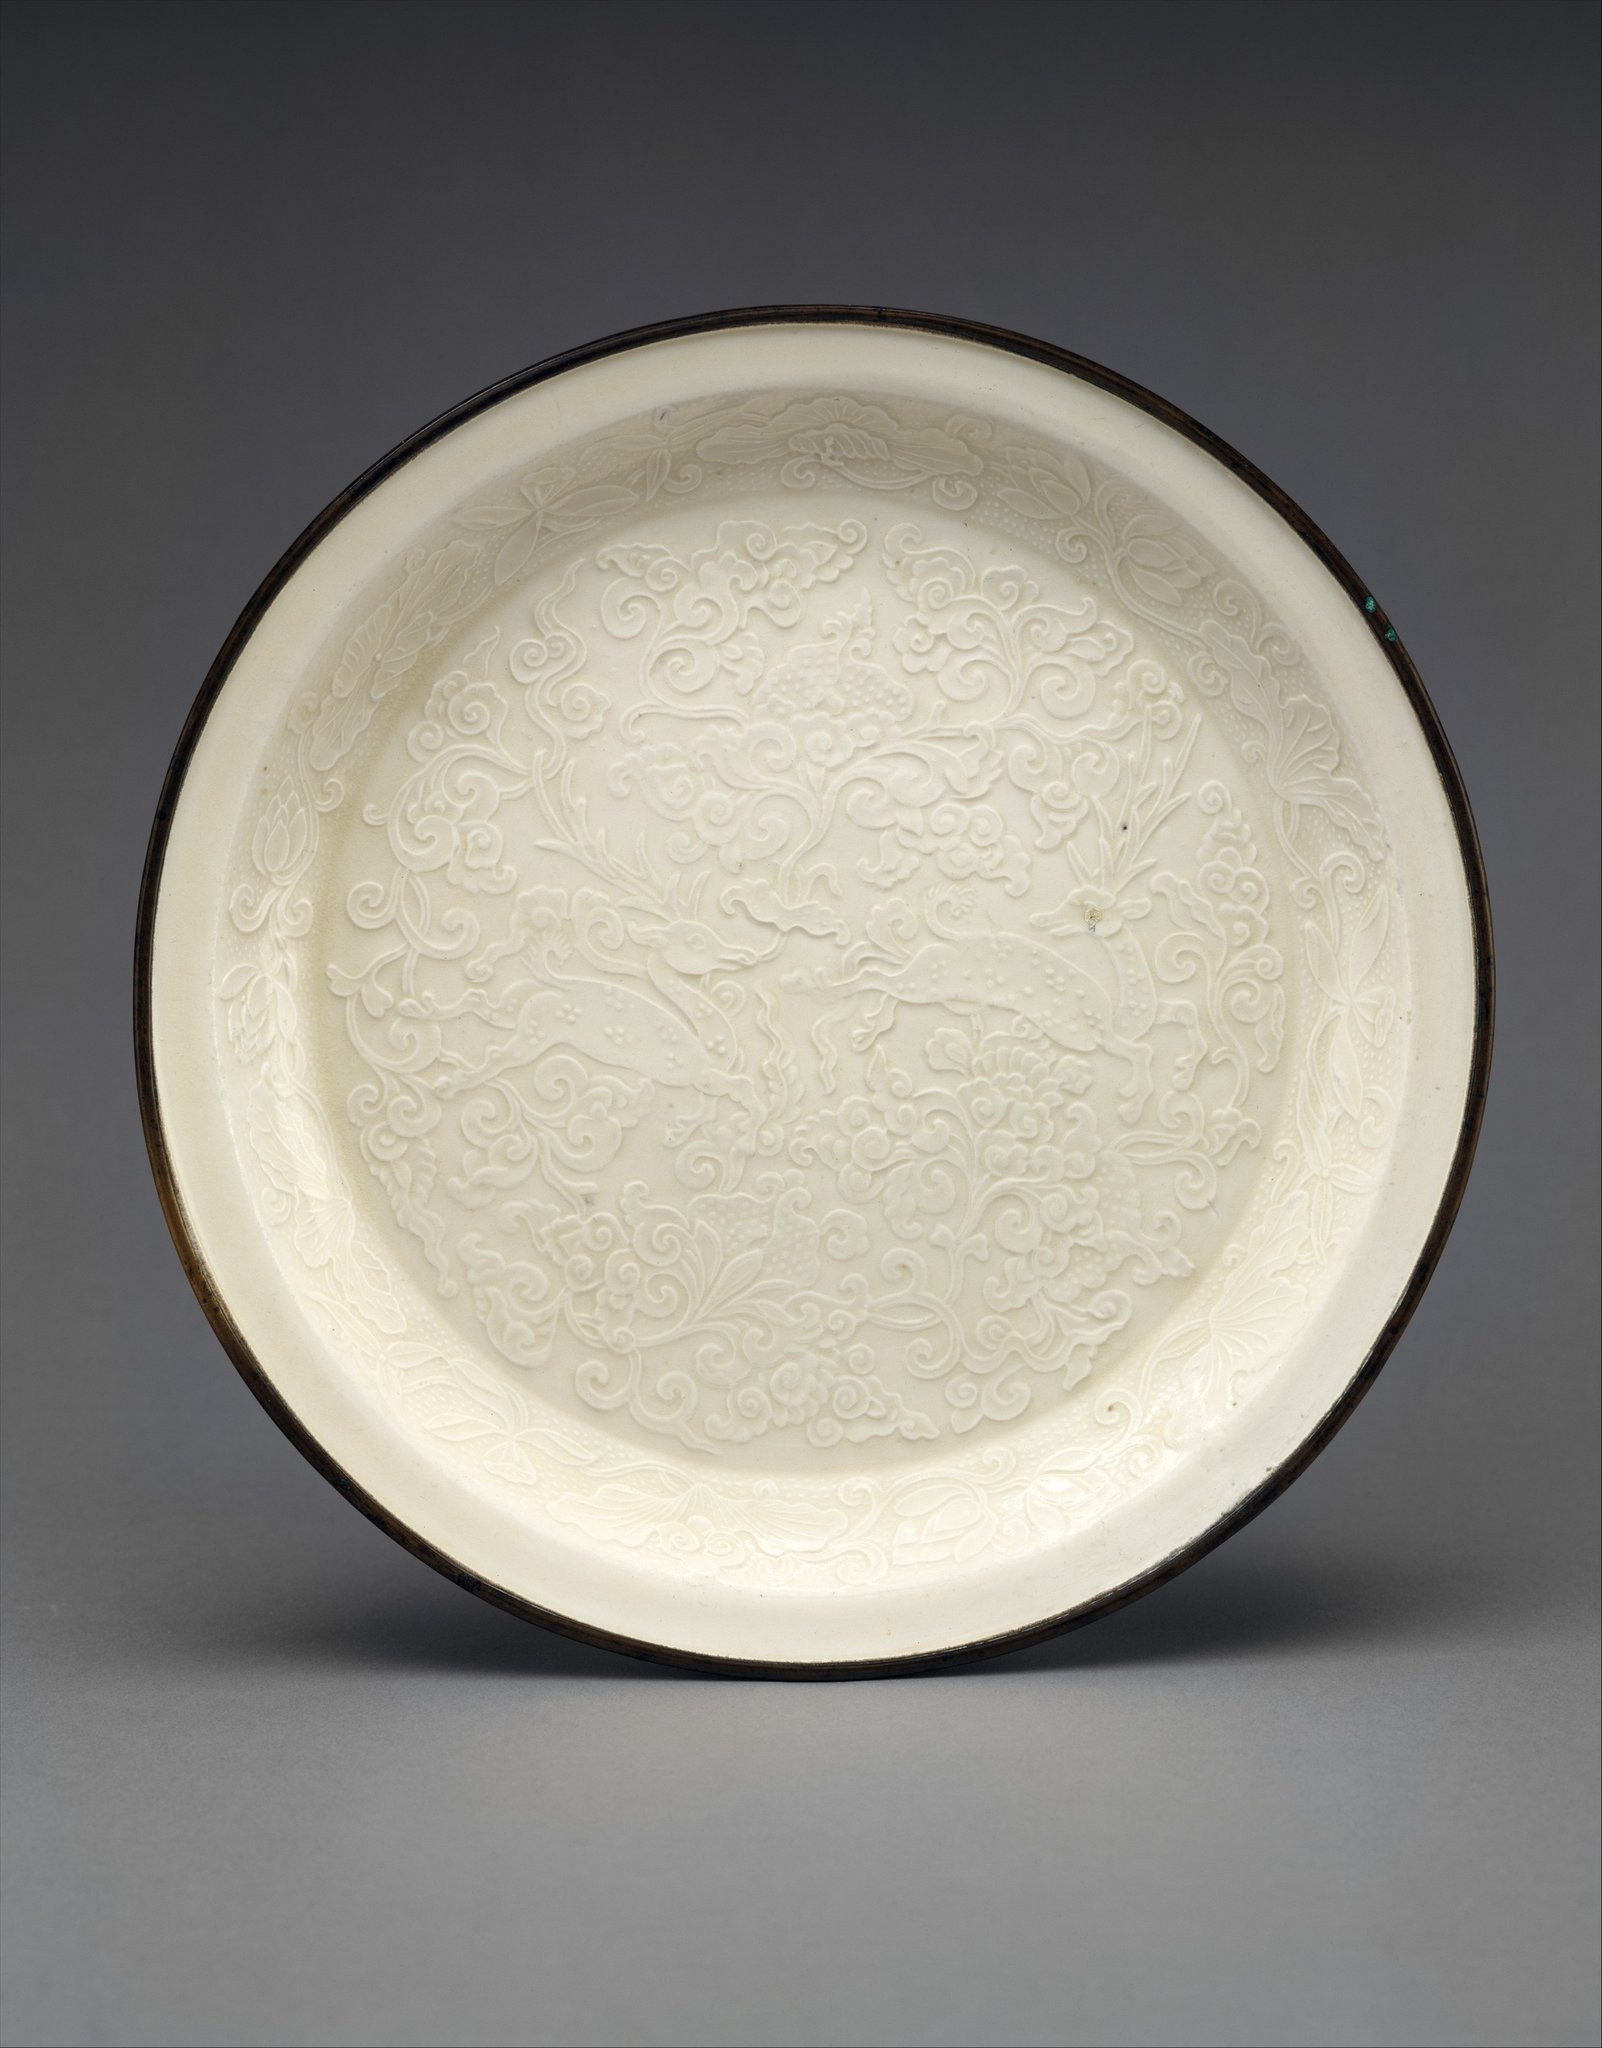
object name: plate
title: Plate with two deer amid flowers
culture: chinese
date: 1101-1300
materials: glaze, ivory, porcelain